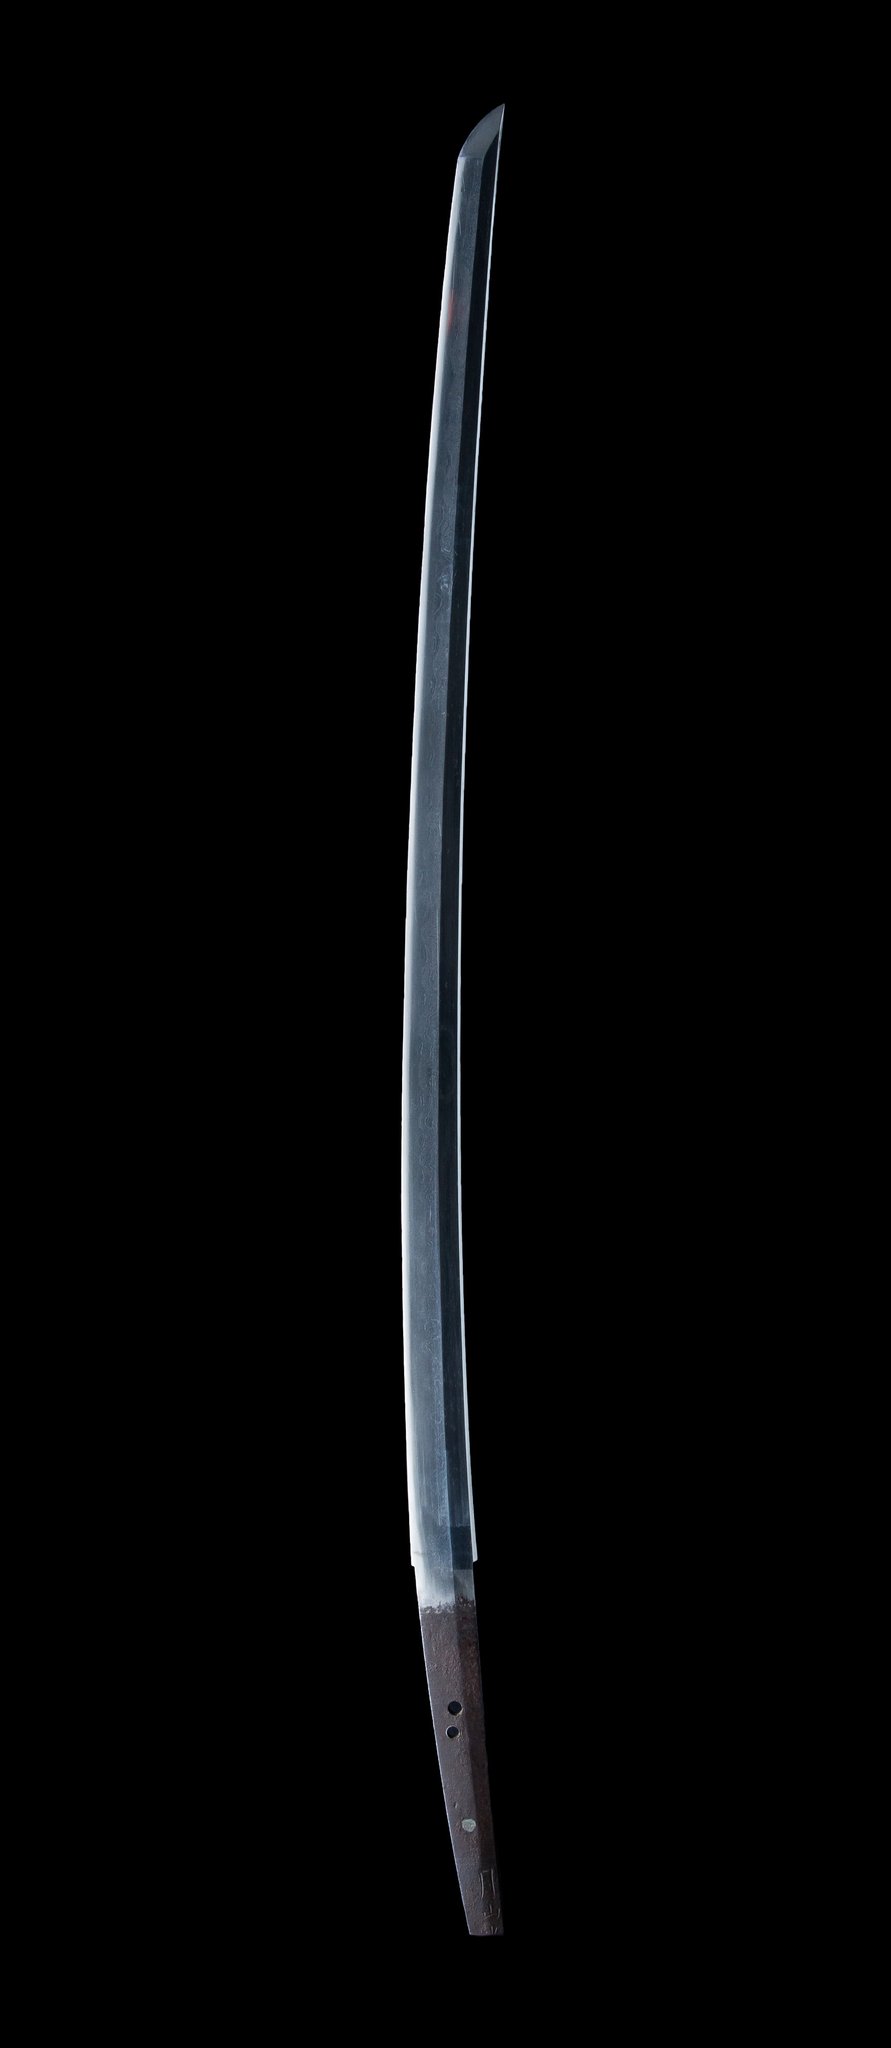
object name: blade for a sword katana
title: Blade for a Sword (Katana)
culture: japanese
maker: gassan mitsu[...]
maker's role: swordsmith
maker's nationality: japanese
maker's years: 1450-1550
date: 1467-1533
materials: steel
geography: japan